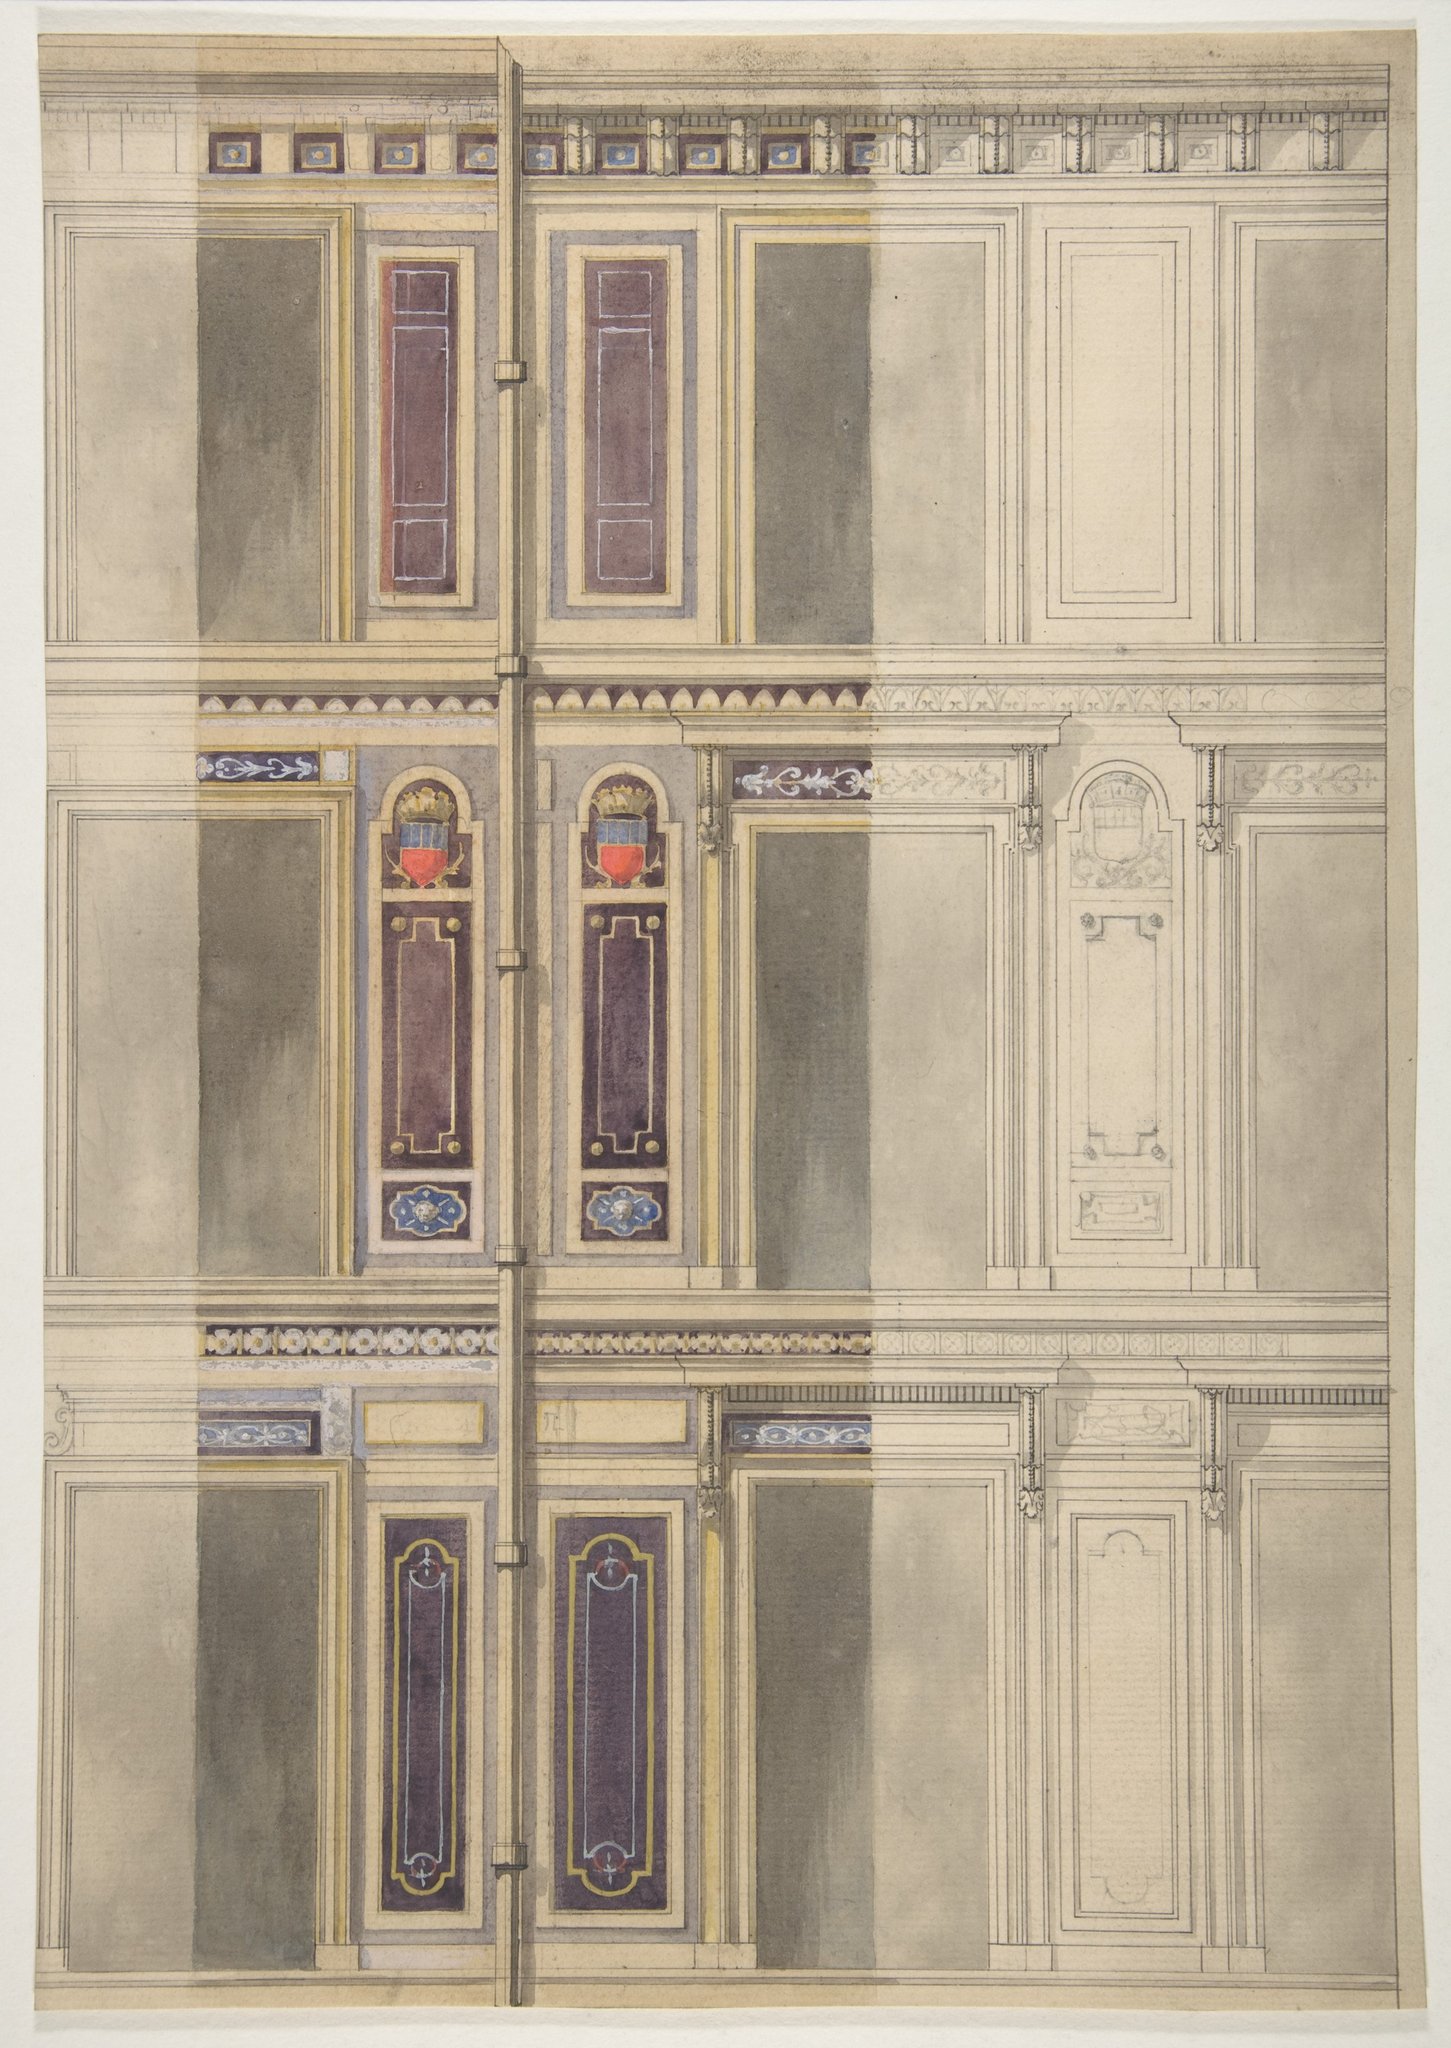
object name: drawing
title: Designs for three windowed storeys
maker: jules-edmond-charles lachaise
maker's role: artist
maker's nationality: french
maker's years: 1897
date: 1830-1897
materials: graphite, ink, paper, watercolor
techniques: pen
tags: architecture,windows